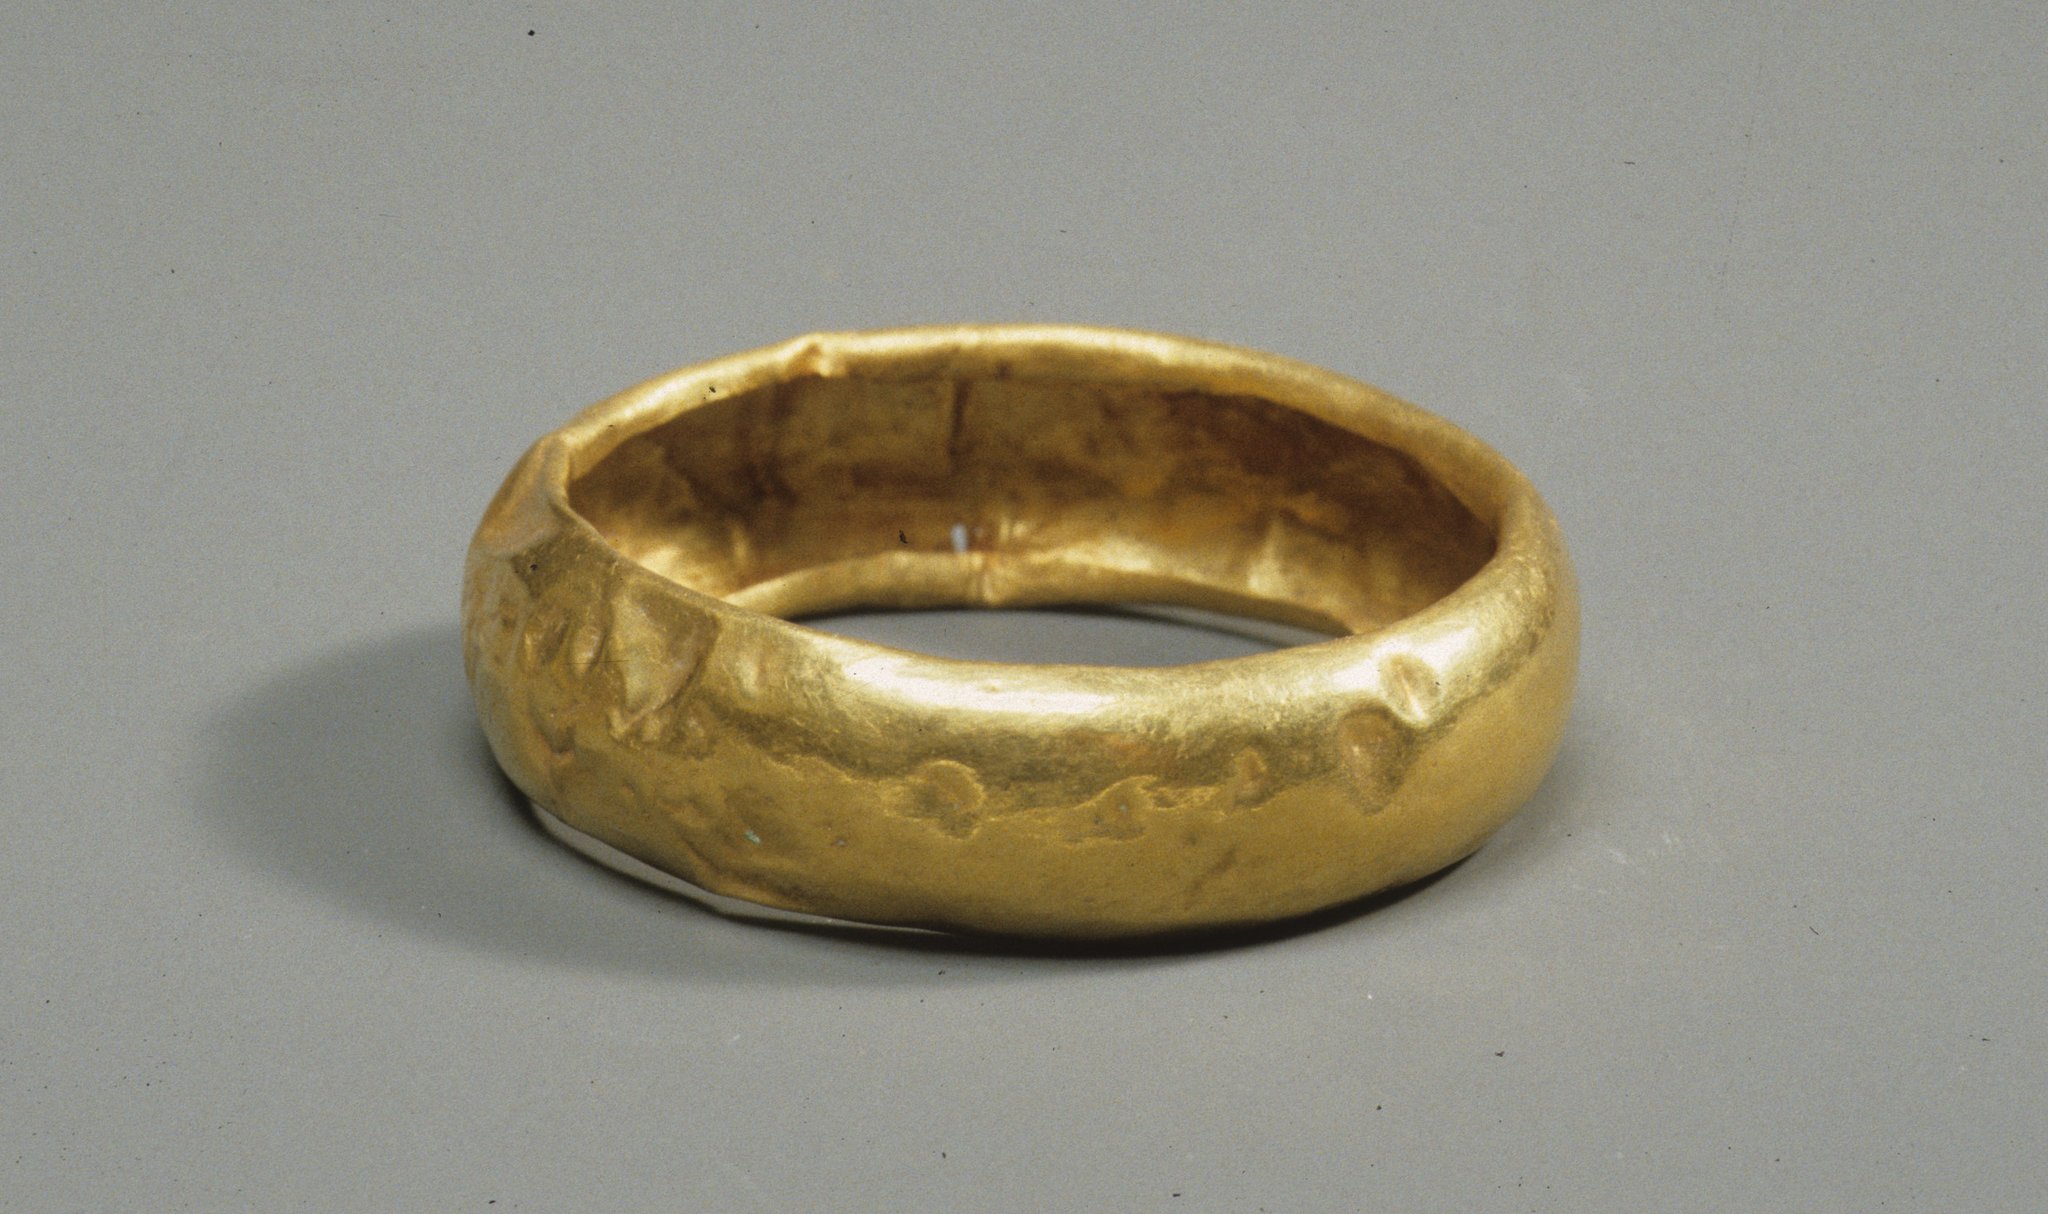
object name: bracelet, child's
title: Child's bracelet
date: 2650 BCE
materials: gold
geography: egypt